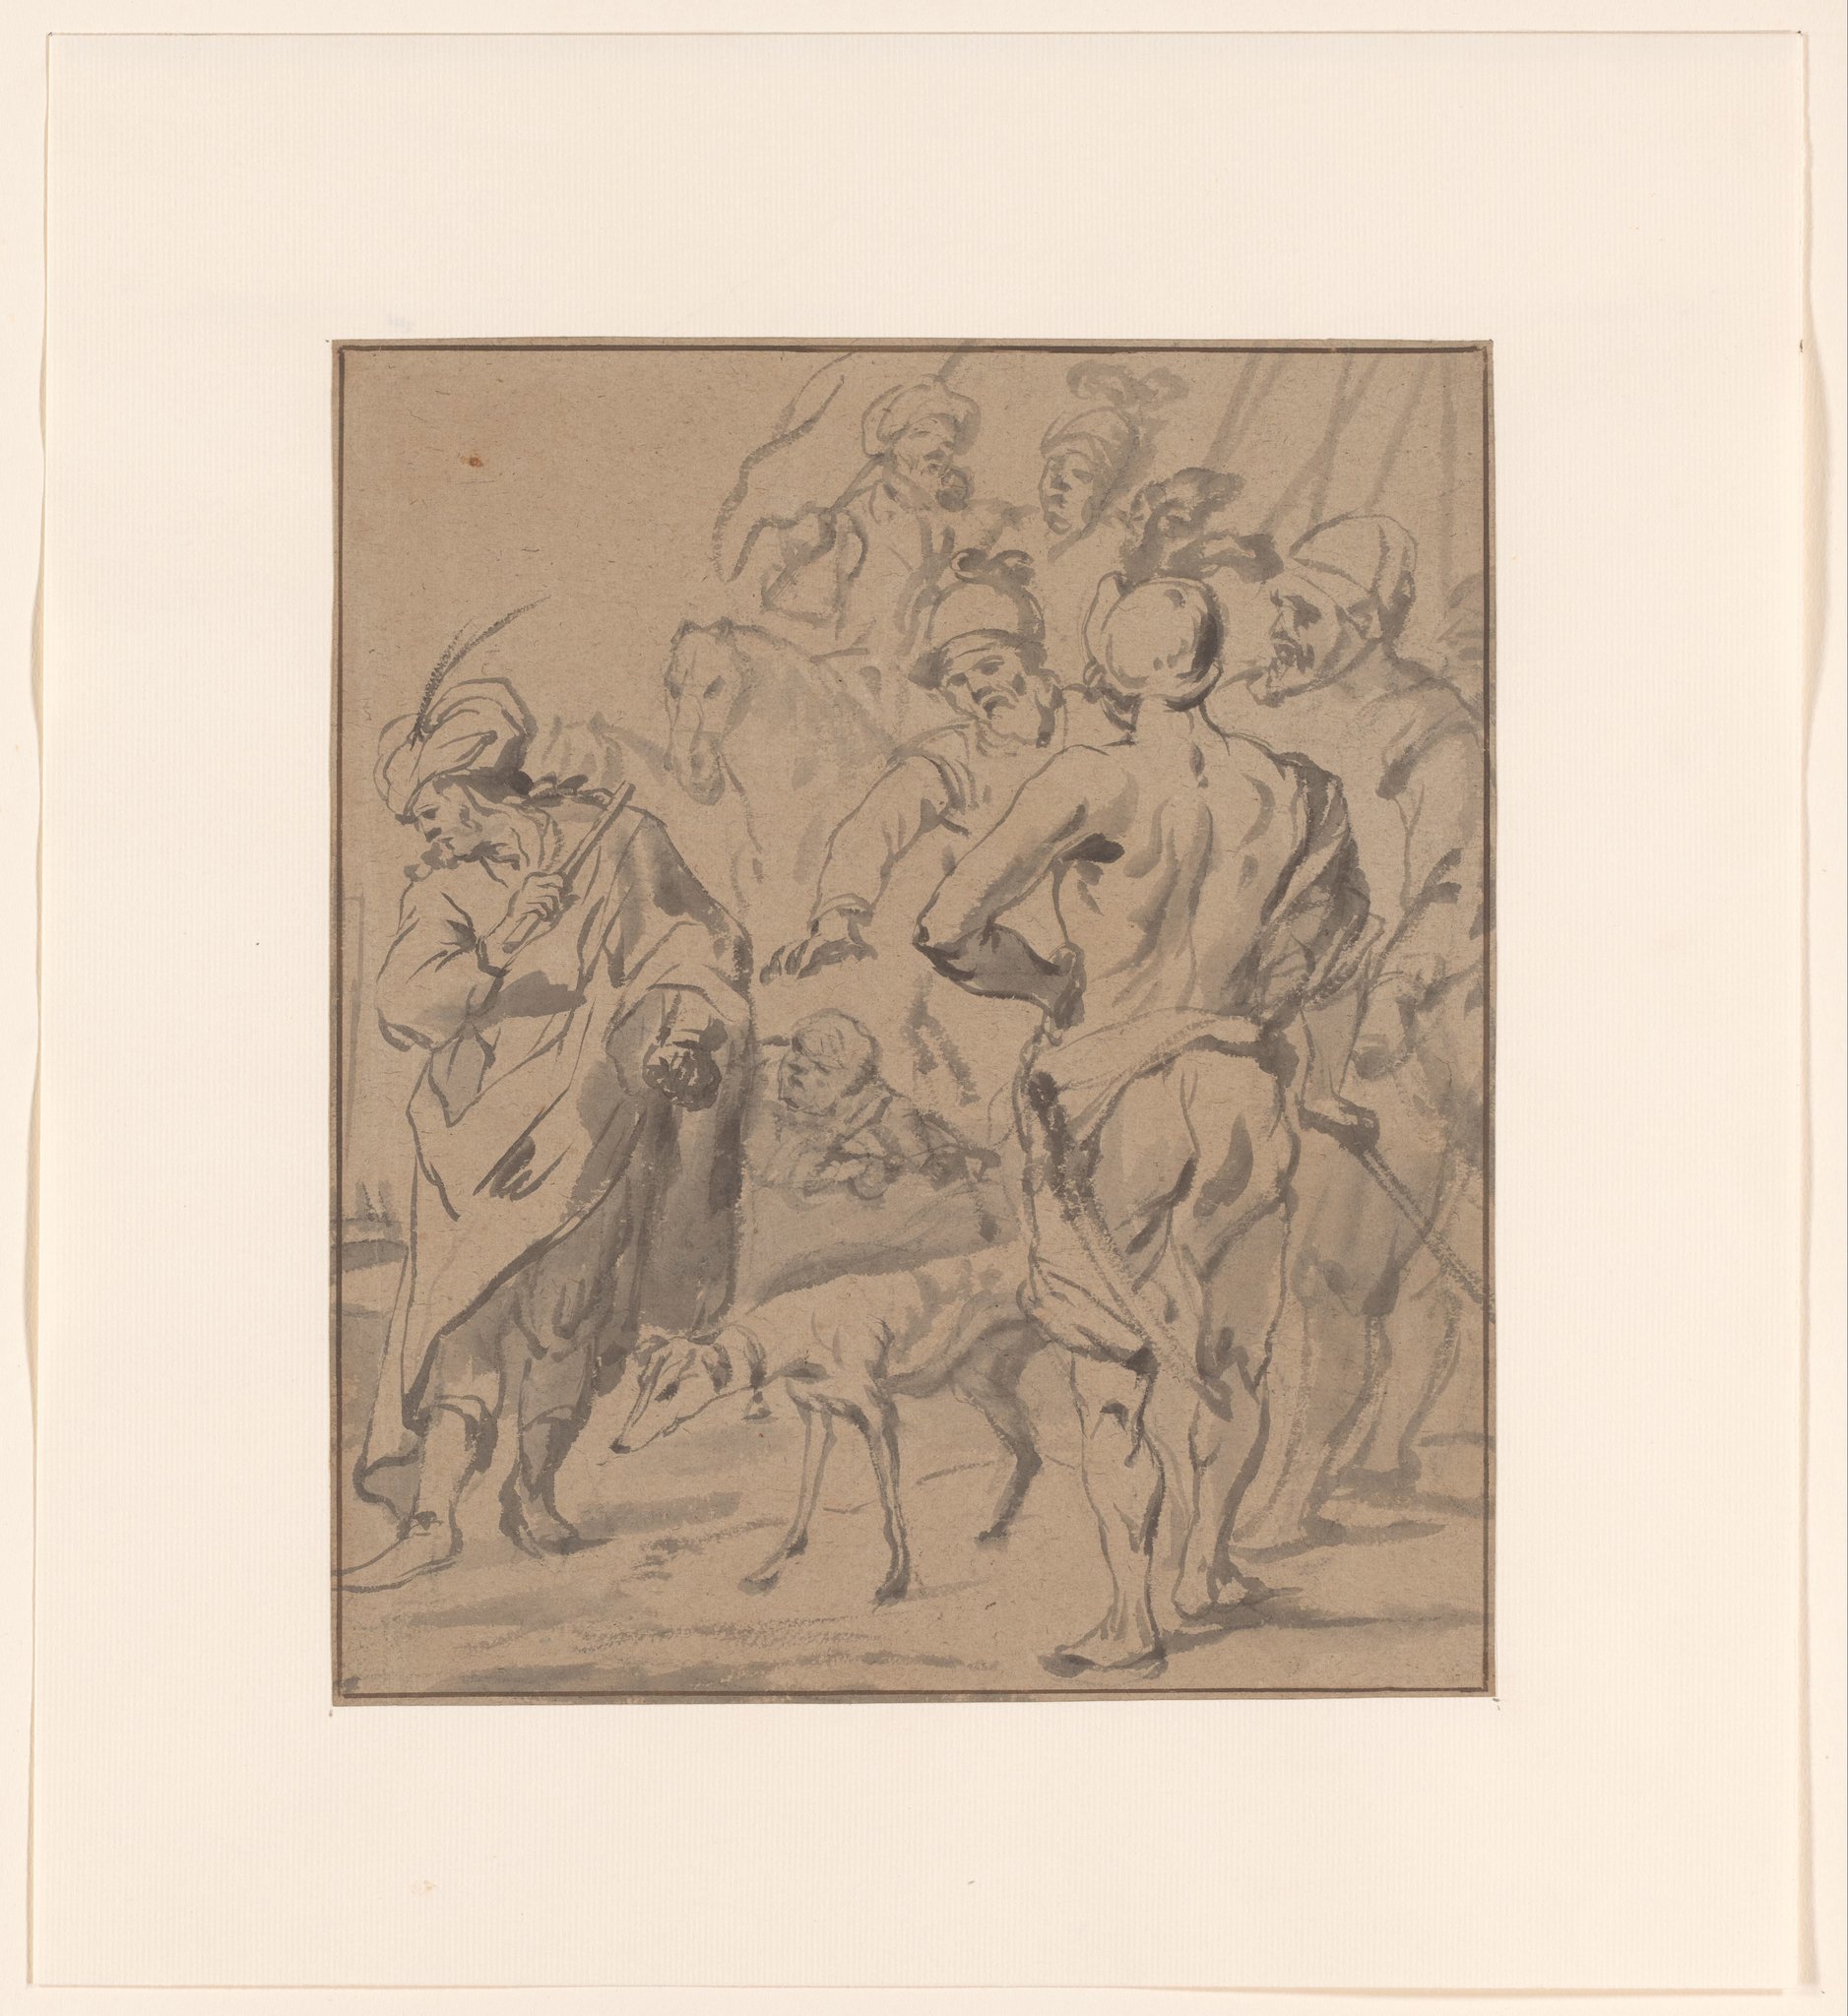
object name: drawing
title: Soldaten, Oosterse personen en een hond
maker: jürgen ovens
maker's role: draughtsman, painter, print maker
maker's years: 1623-1678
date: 1633-1678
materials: paper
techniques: brush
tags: asiatic races and peoples, the soldier off duty, dog